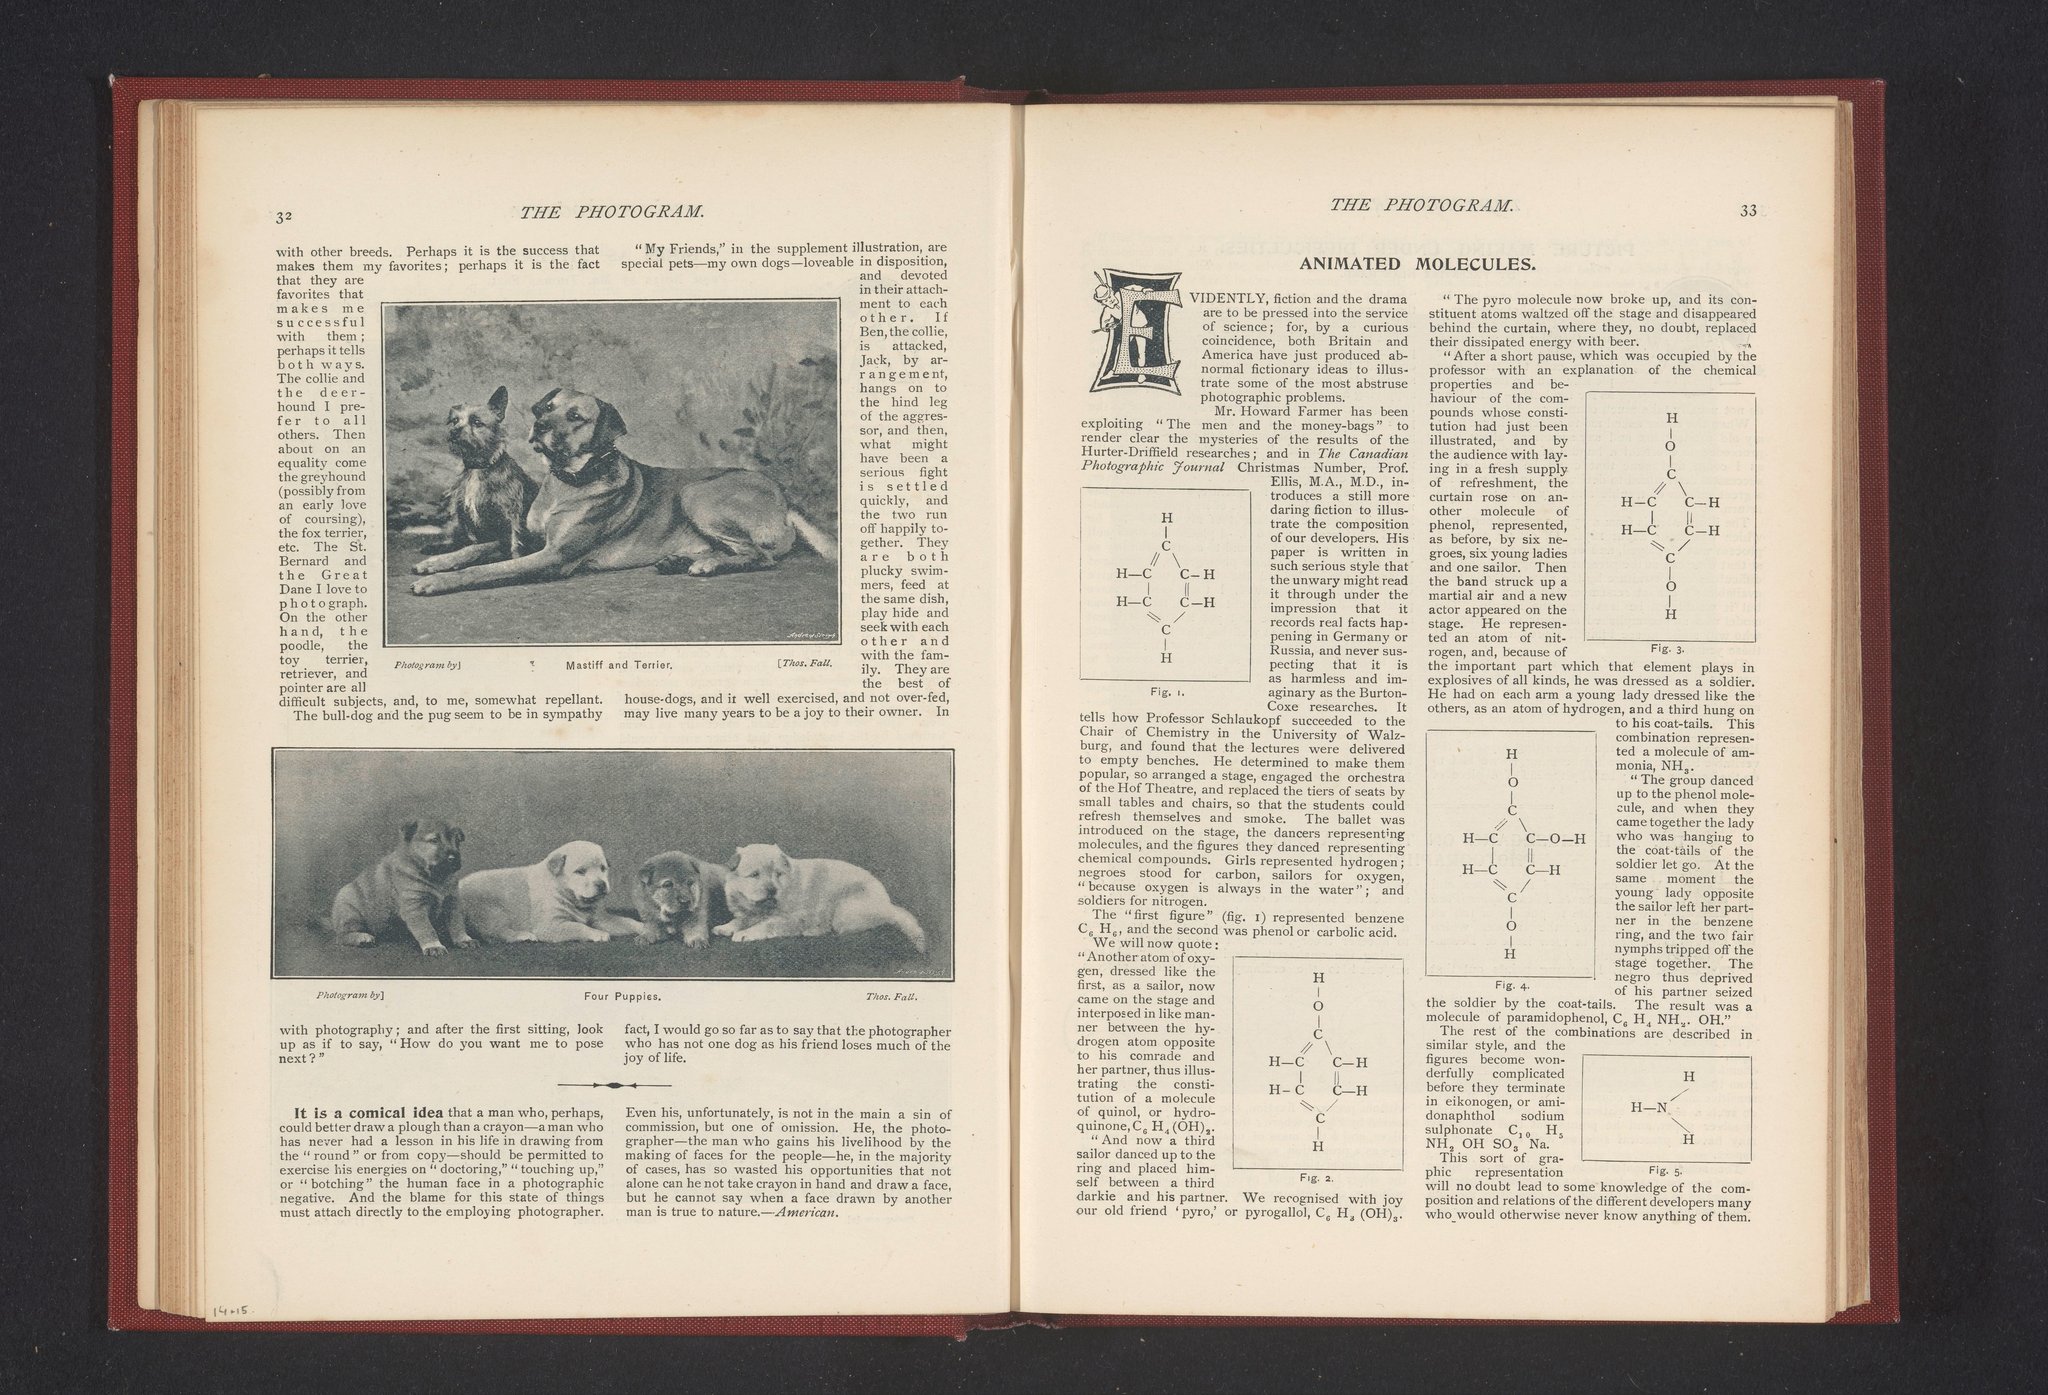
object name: page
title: Mastiff en Terriër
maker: thomas fall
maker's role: fotograaf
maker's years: 1833-1900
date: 1889-1894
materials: paper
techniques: autotype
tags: dog